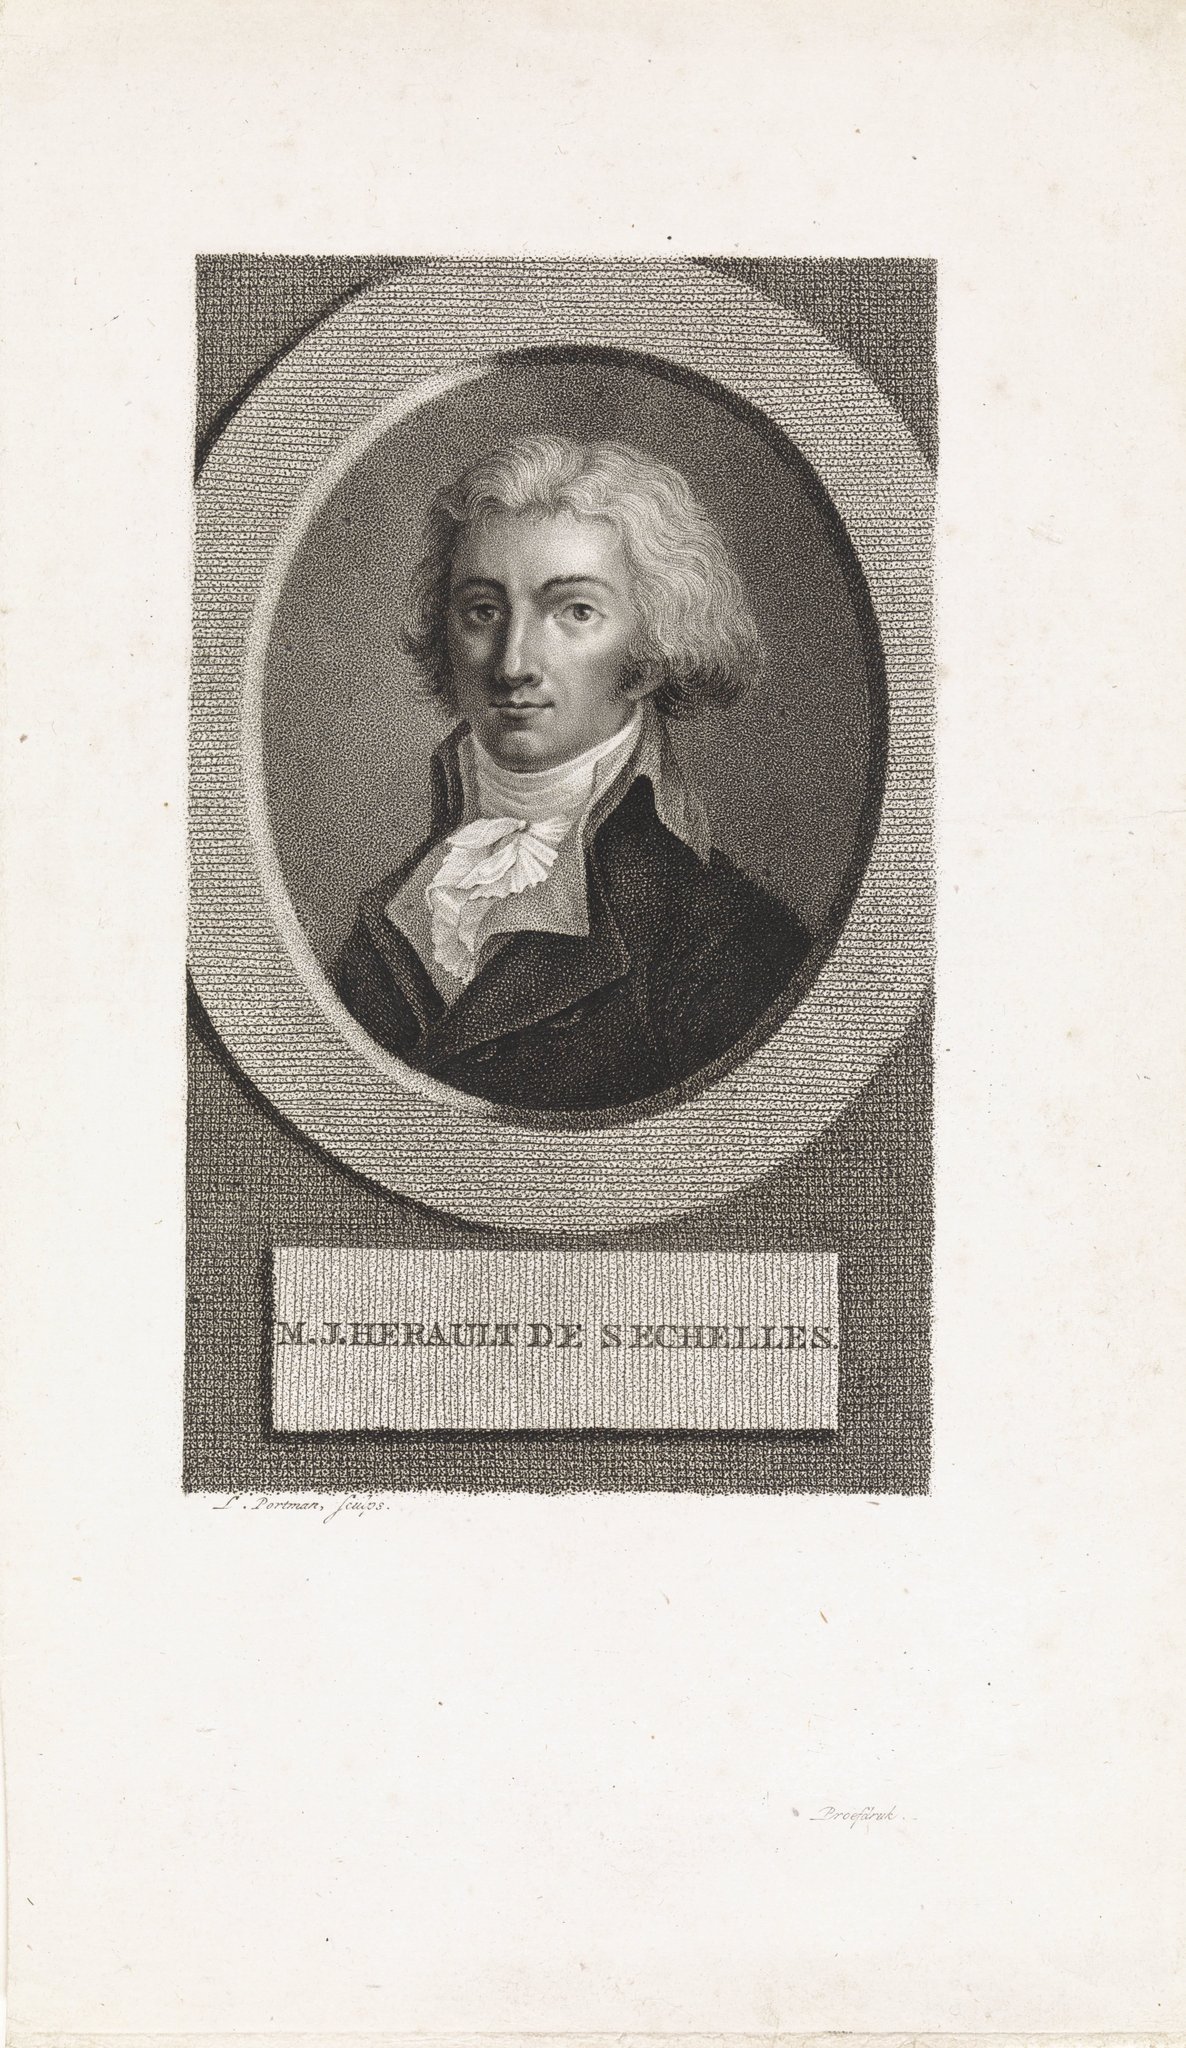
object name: print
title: Portret van de Franse politicus Marie-Jean Hérault de Séchelles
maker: ludwig gottlieb portman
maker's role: print maker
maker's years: 1772-1828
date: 1803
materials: paper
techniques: stippled etching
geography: amsterdam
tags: paris, politician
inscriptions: collector's mark: Lugt 2228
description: Prent ook gebruikt als illustratie in: Tafereelen van de staatsomwenteling in Frankrijk, deel 17, p. 130. Amsterdam: Johannes Allart, 1803.